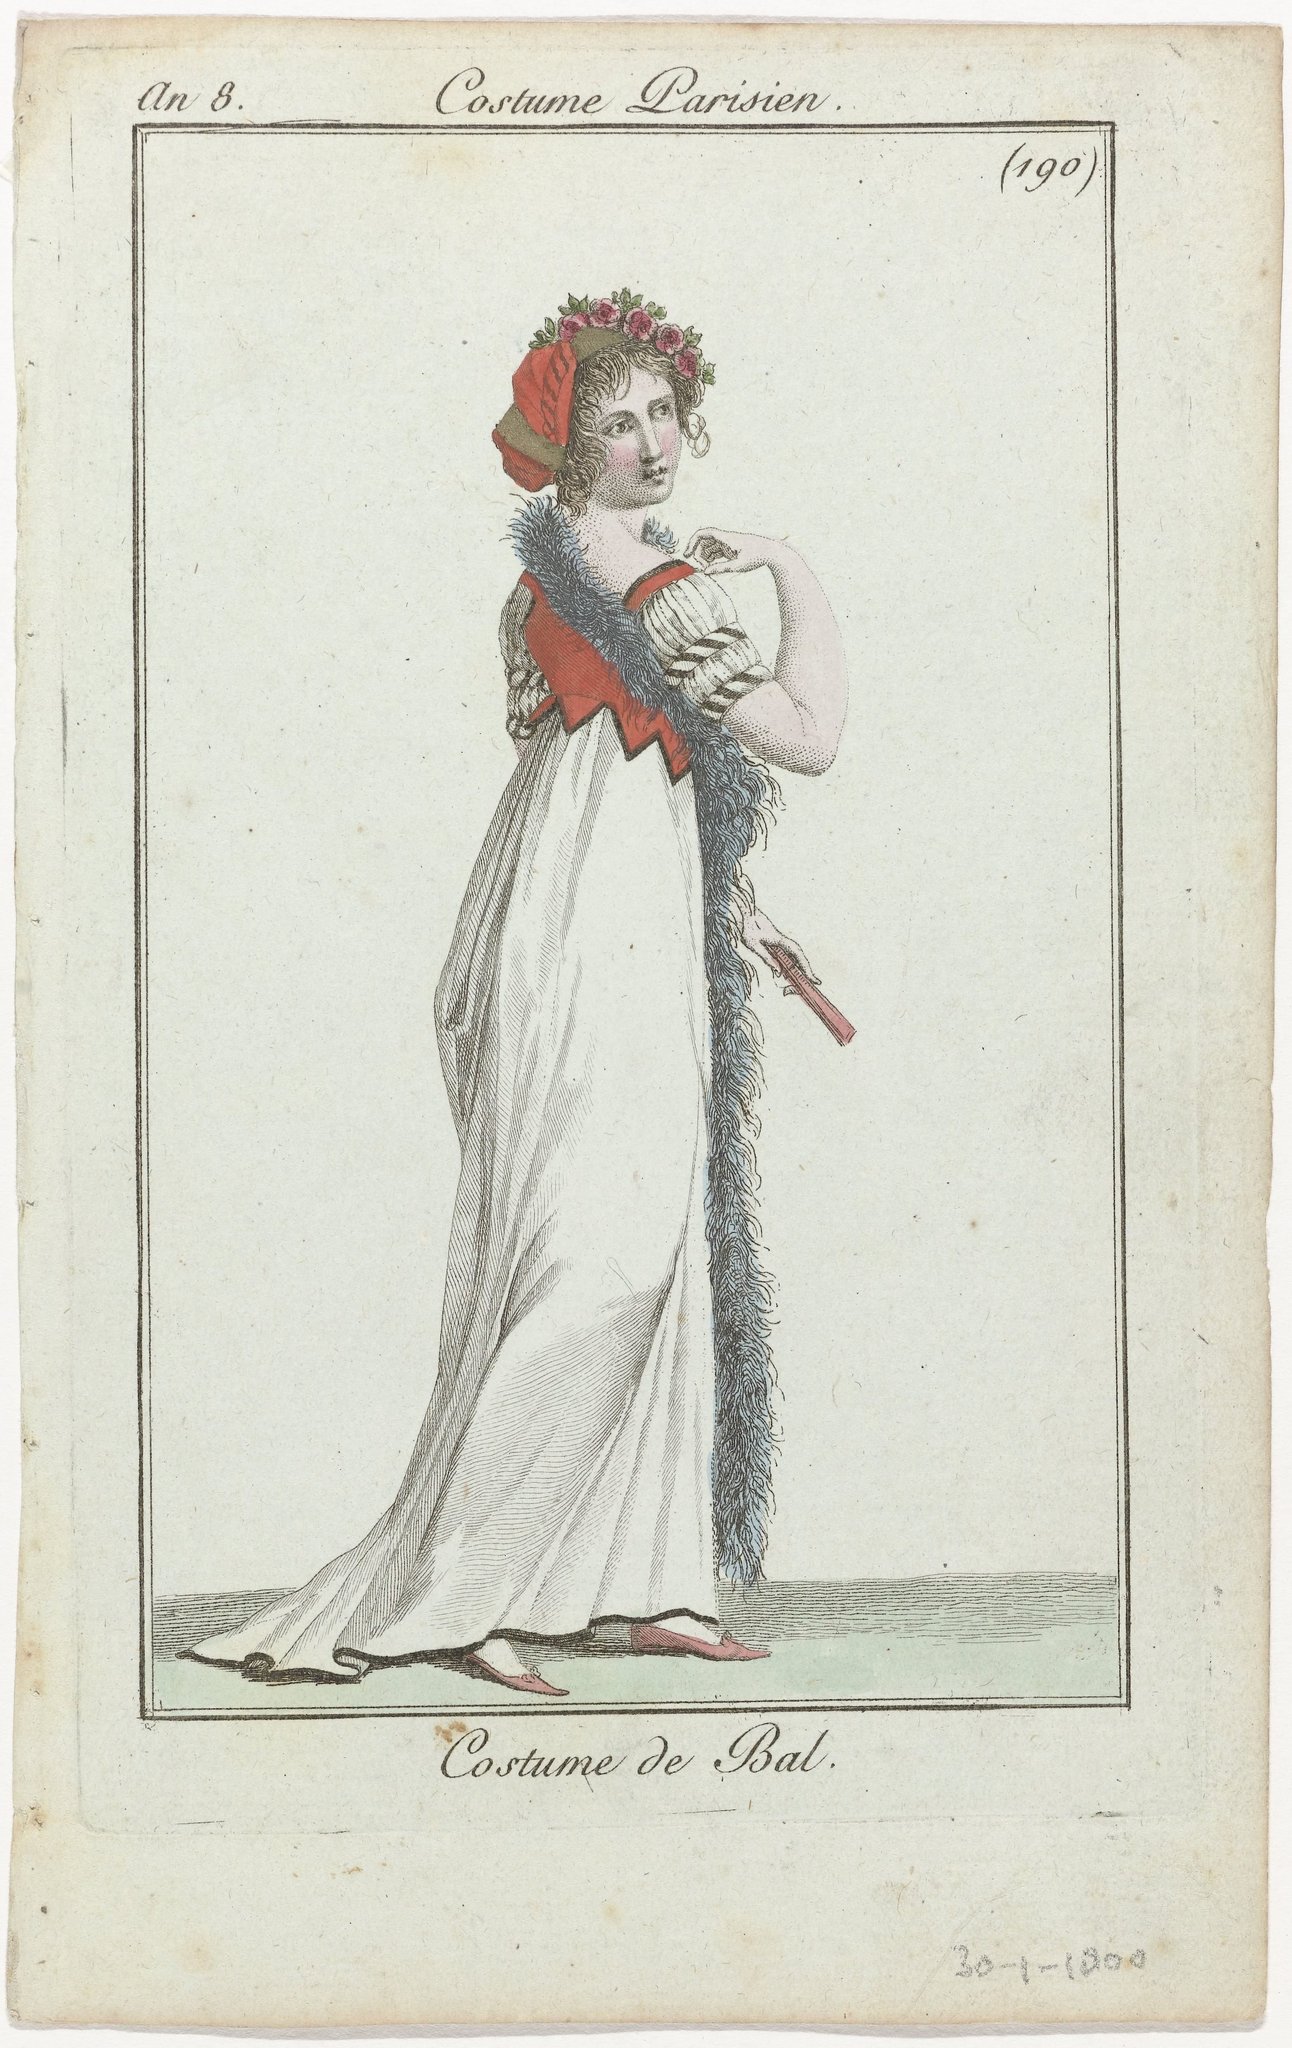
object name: fashion print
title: Journal des Dames et des Modes, Costume Parisien, 30 janvier 1800, An 8, (190) : Costume de Bal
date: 1800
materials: paper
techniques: engraving, hand coloring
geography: paris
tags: clothing for the upper part of the body (+ women's clothes), dress, gown: ball gown (+ women's clothes), head-gear: cap (+ women's clothes), fashion plates, shoes, sandals (+ women's clothes), fan (+ women's clothes)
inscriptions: caption: ‘Costume de Bal.’, title: ‘Costume Parisien.’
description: Vrouw, op de rug gezien, in een kostuuum voor een bal. Baljapon met contrasterend lijfje, korte mouwen en sleep afgezet met zwarte bies. Accessoires: muts versierd met bloemen, bontstola (palatine), waaier, platte schoenen met puntige neuzen. De prent maakt deel uit van het modetijdschrift Journal des Dames et des Modes, uitgegeven door Pierre de la Mésangère, Parijs, 1797-1839.